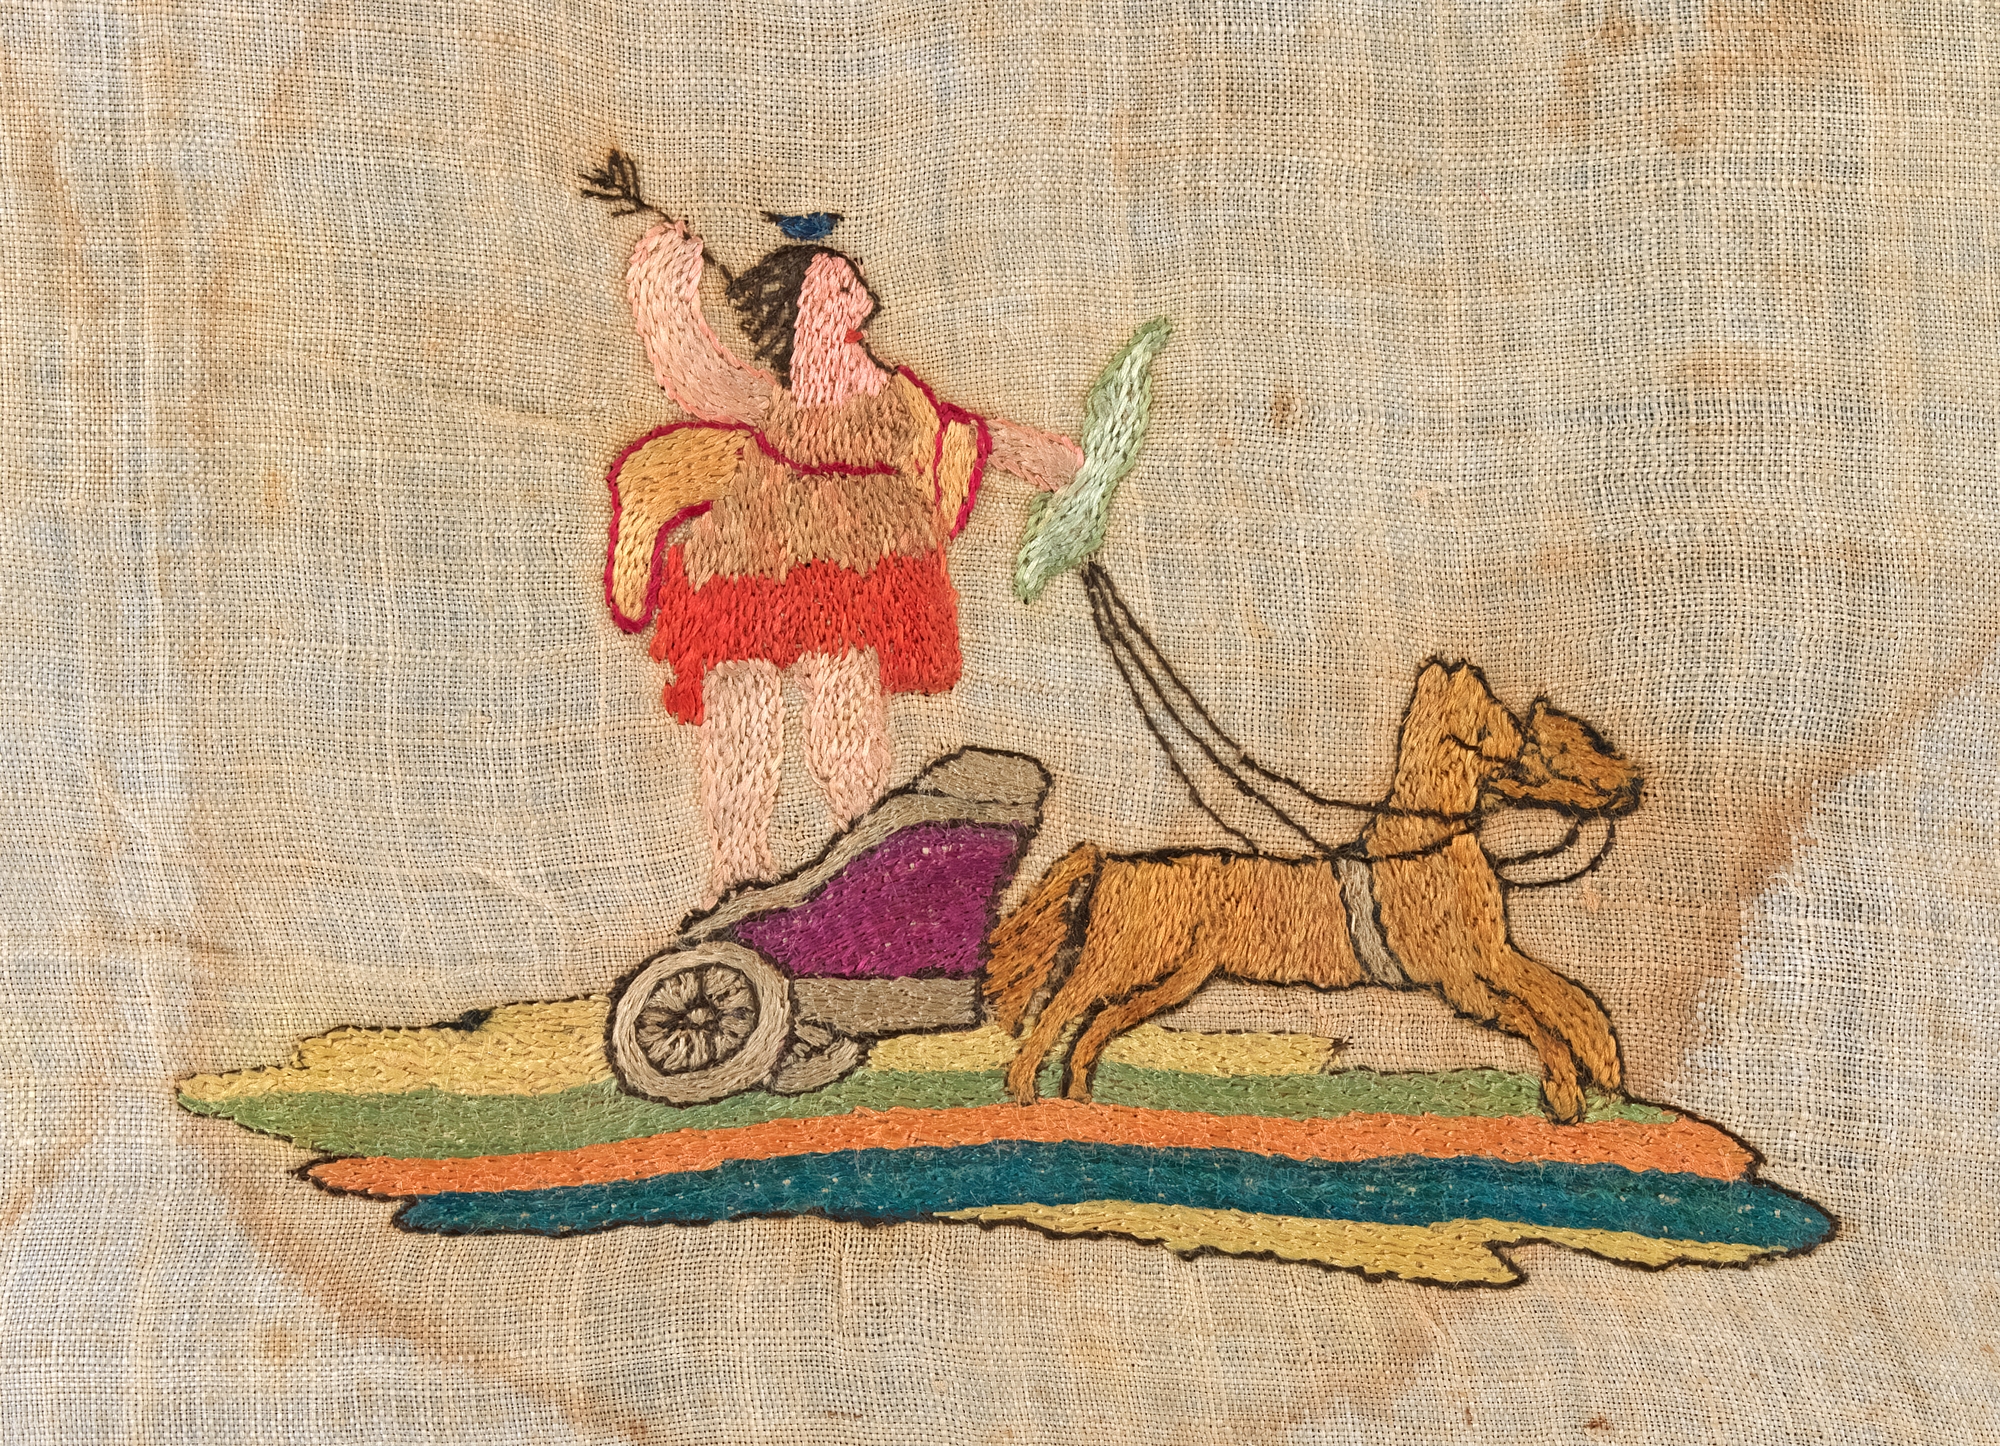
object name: handkerchief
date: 1701-1733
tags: human figures,horses,lions,chariots